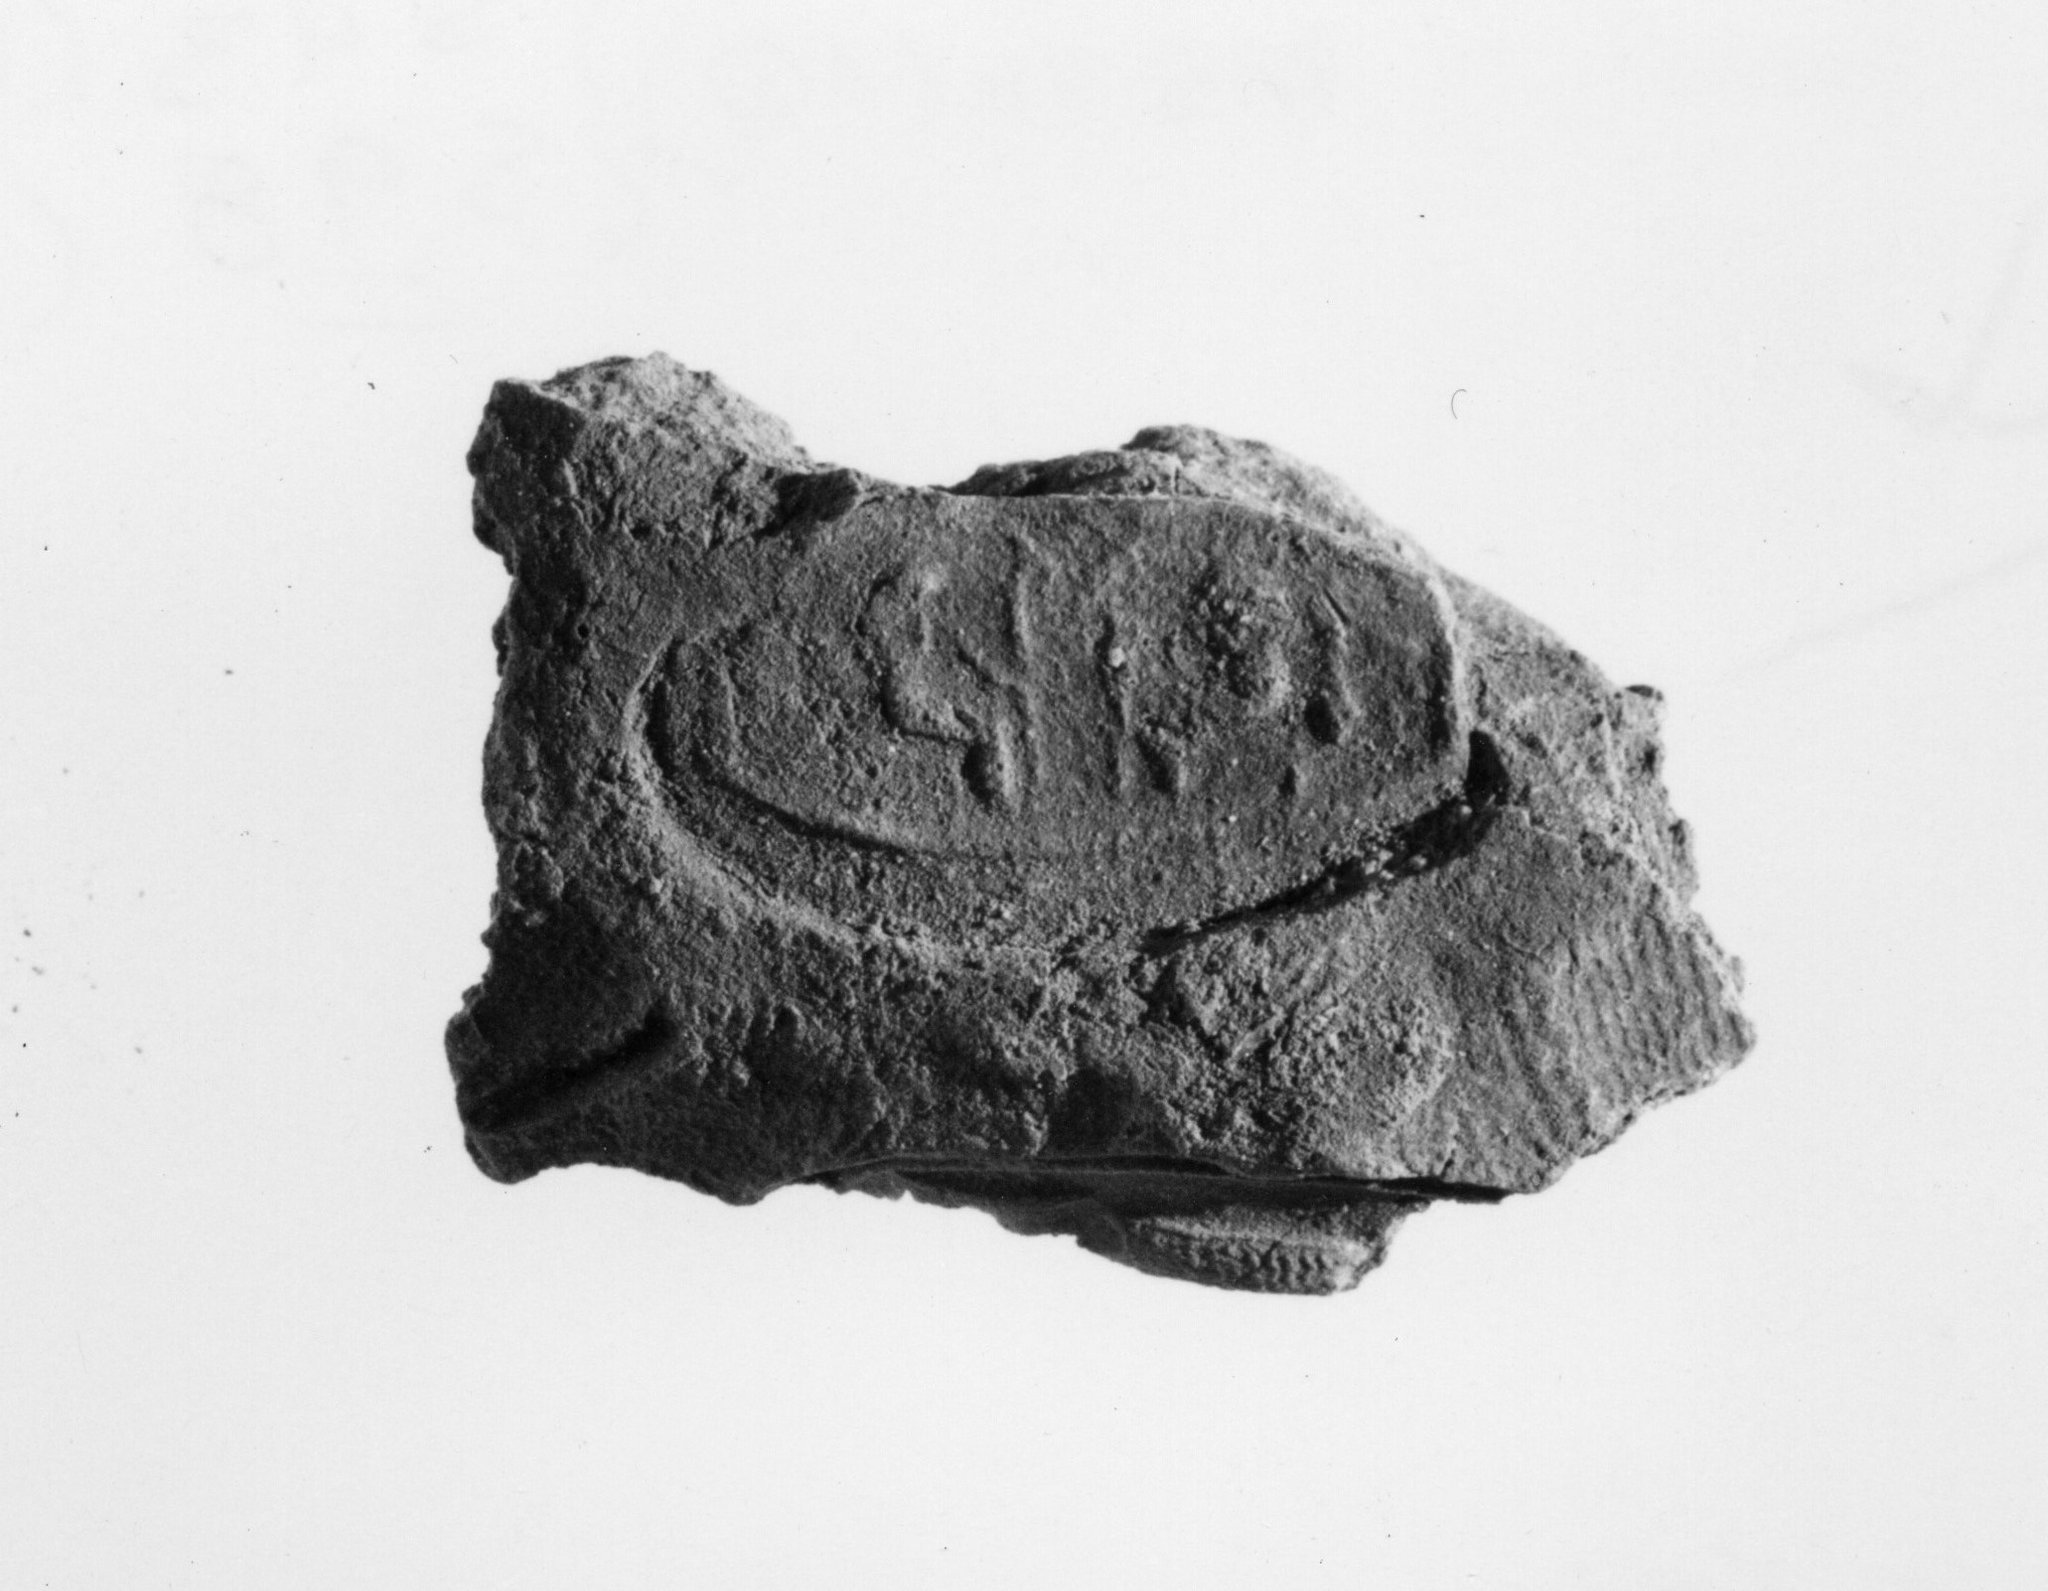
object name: sealing, nebmaatre, amenhotep iii,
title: Document Sealing With Multiple Seal Impressions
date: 1390-1352 BCE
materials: mud